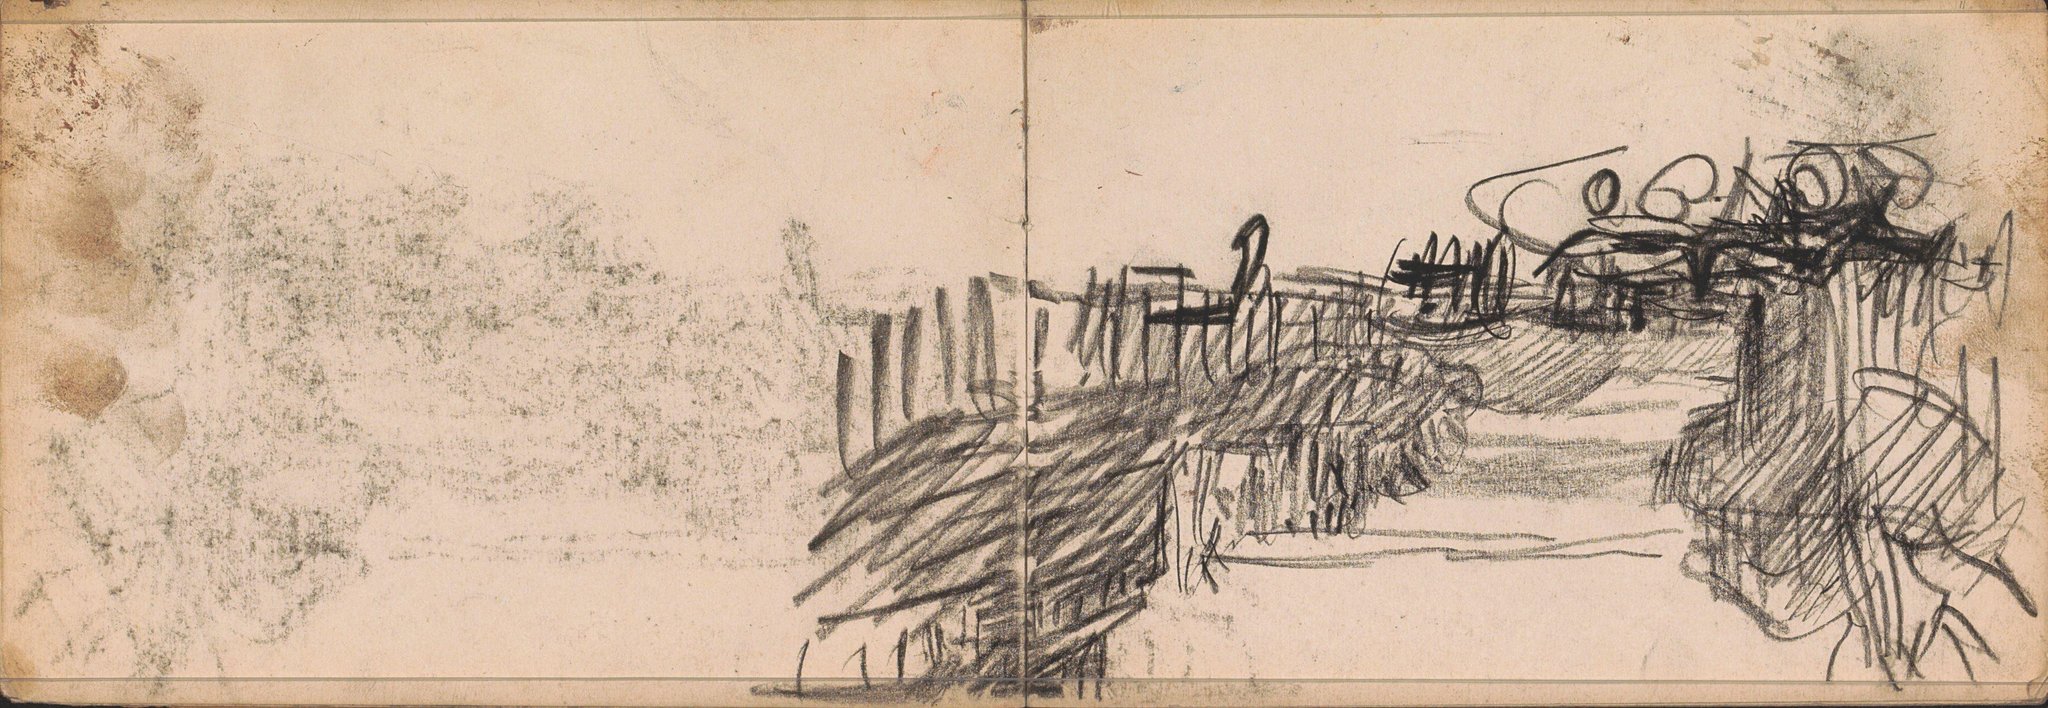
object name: sketchbook leaf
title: Laan met rijtuigen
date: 1875-1934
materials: chalk, paper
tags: four-wheeled, animal-drawn vehicle, e.g.: cab, carriage, coach, lane, alley, paris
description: Mogelijk in Parijs. Pagina 10 en pagina 11 uit schetsboek XLVI met 32 pagina's.